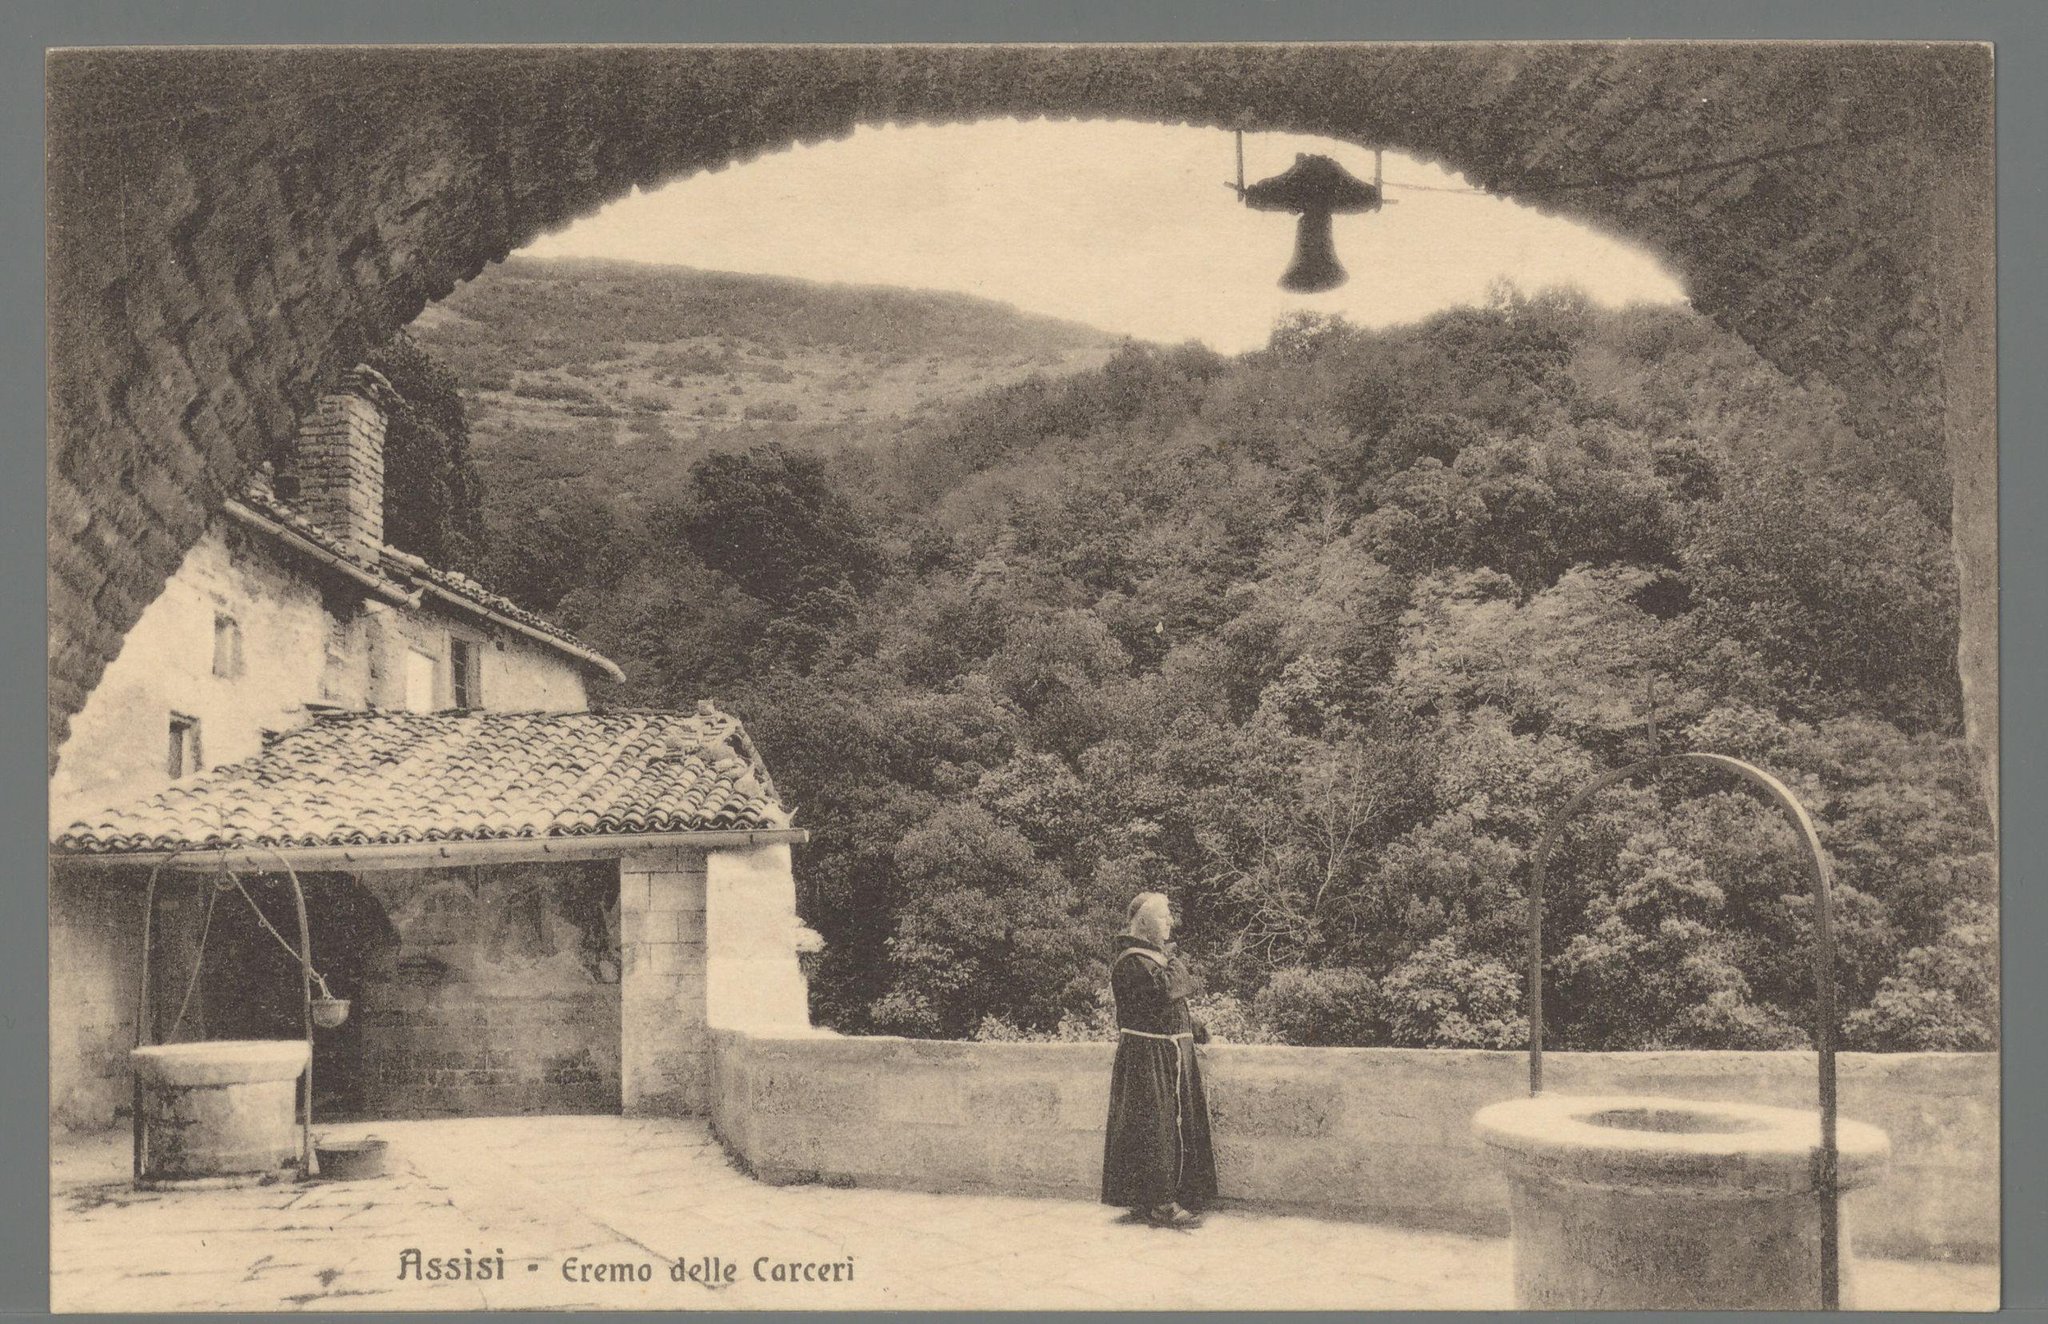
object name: photomechanical print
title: Assisi. Eremo delle Carceri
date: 1906-1930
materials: cardboard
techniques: photograph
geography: como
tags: abbey, monastery, convent ~ roman catholic church, monk(s), friar(s)